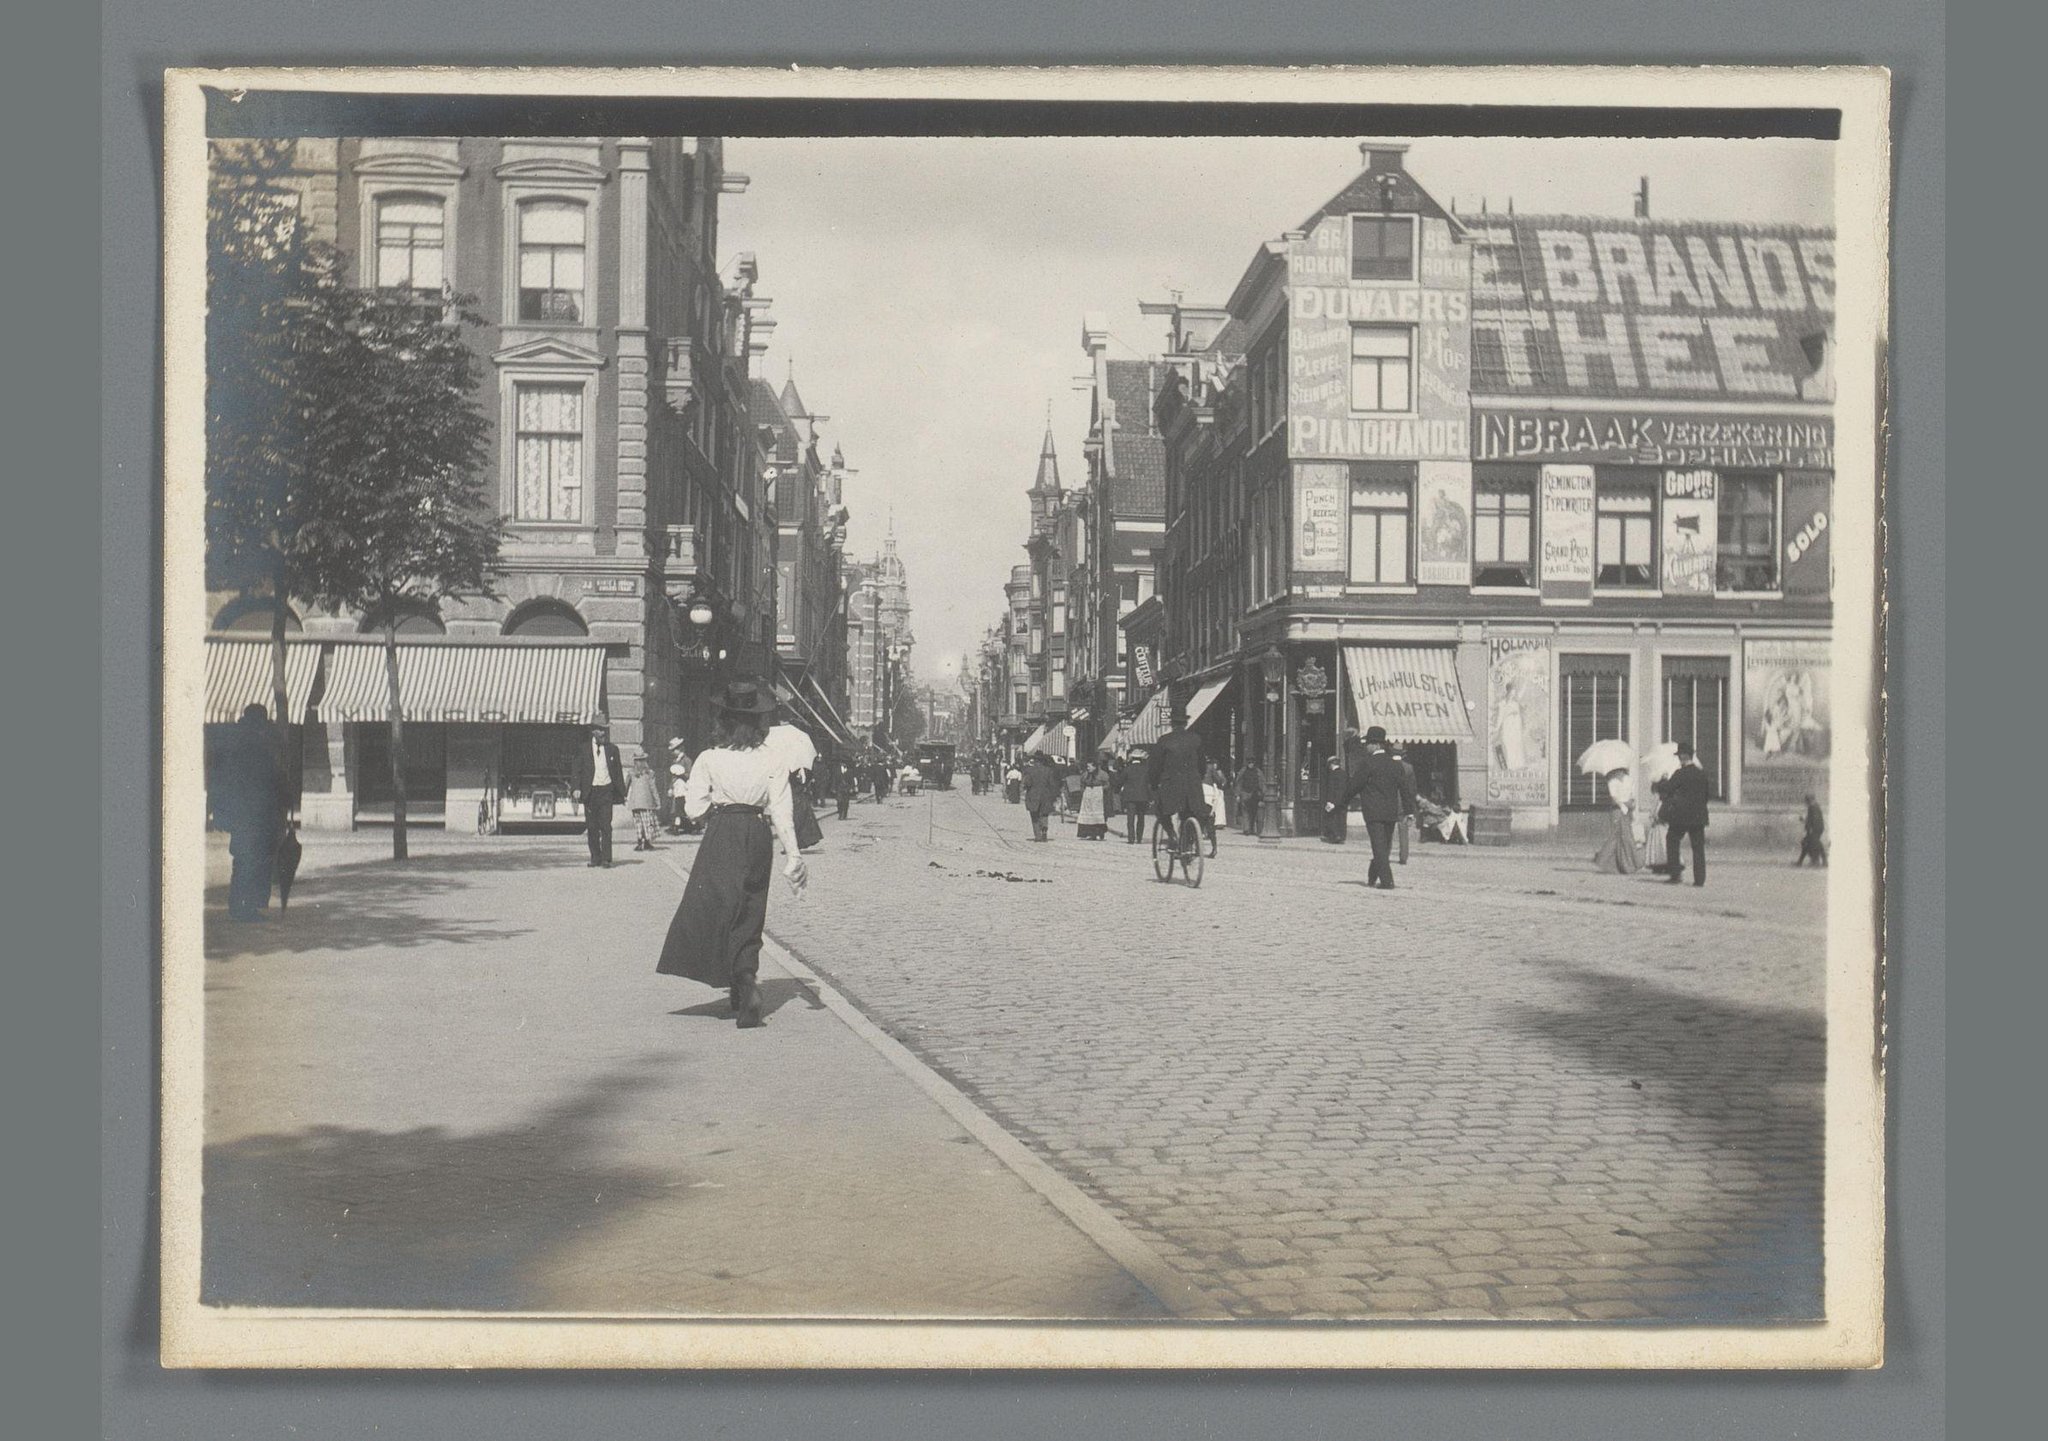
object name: photograph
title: Leidsestraat gezien vanaf het Leidseplein, Amsterdam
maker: willem de jong (fotograaf)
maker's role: arts, fotograaf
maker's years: 1864-1918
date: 1895-1911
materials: paper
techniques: gelatin silver print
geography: amsterdam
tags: square, place, circus, etc., walking